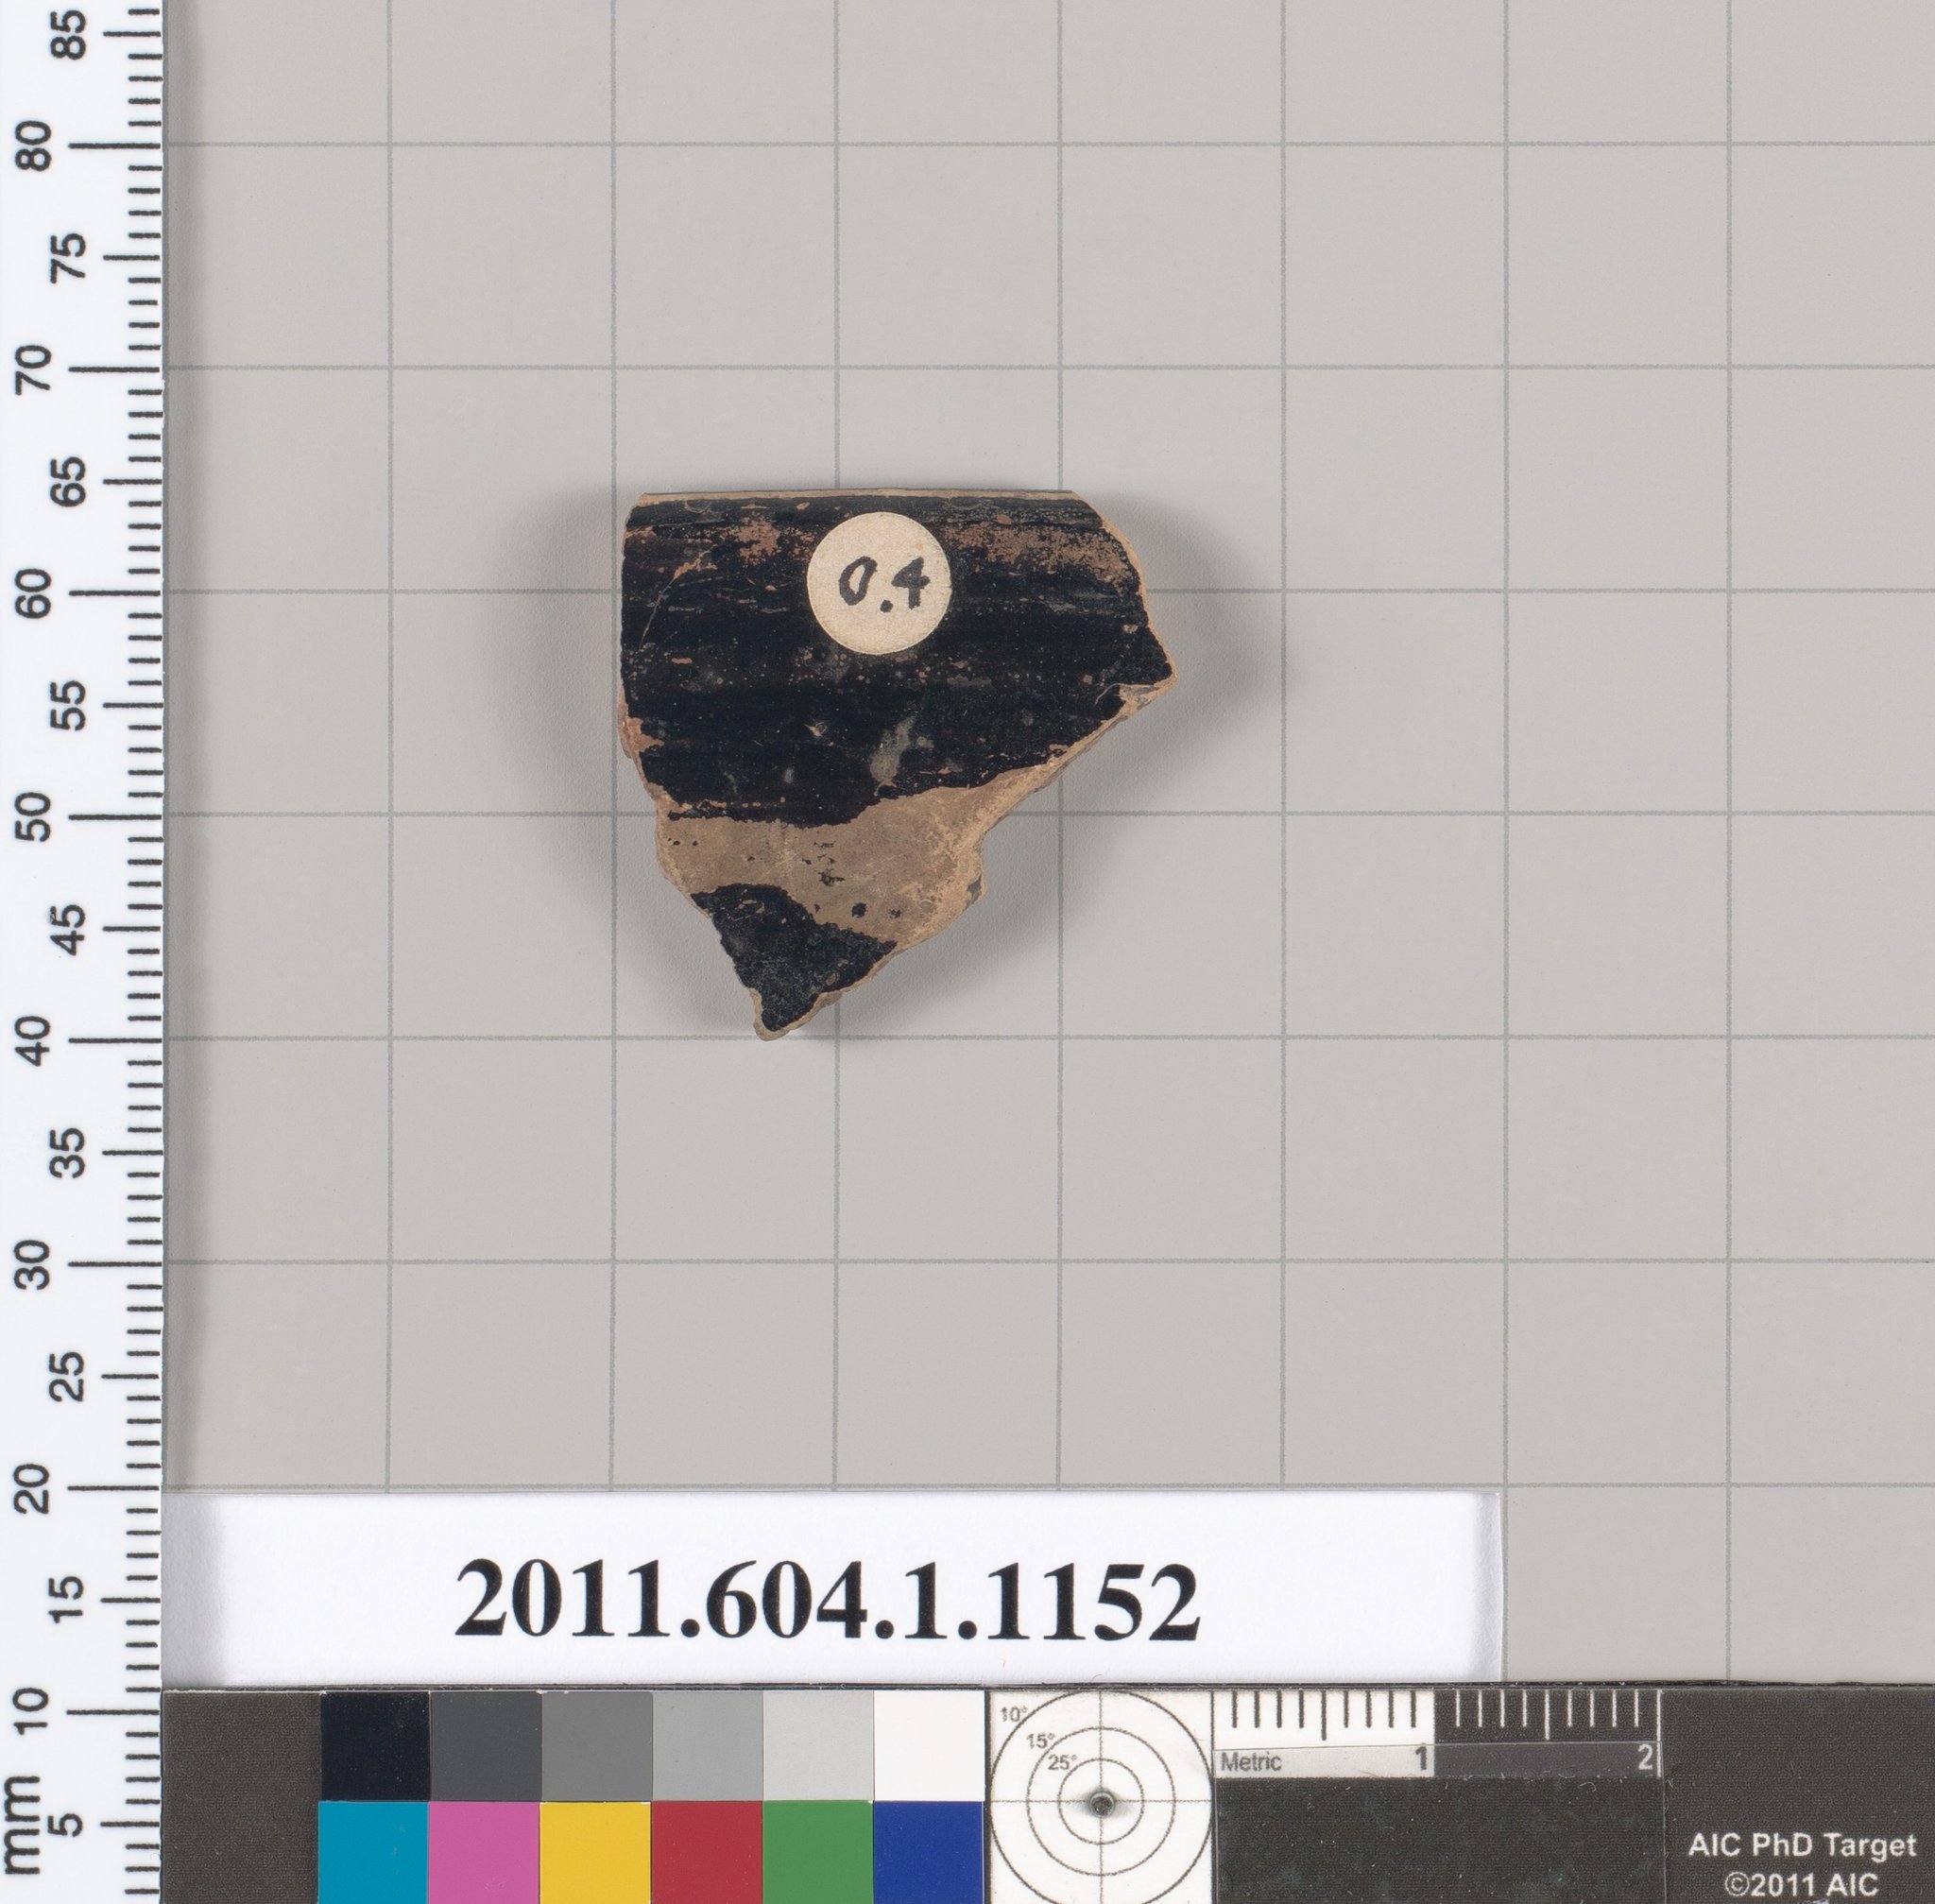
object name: kylix fragment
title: Terracotta rim fragment of a kylix (drinking cup)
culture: greek, attic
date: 500-451 BCE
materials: terracotta